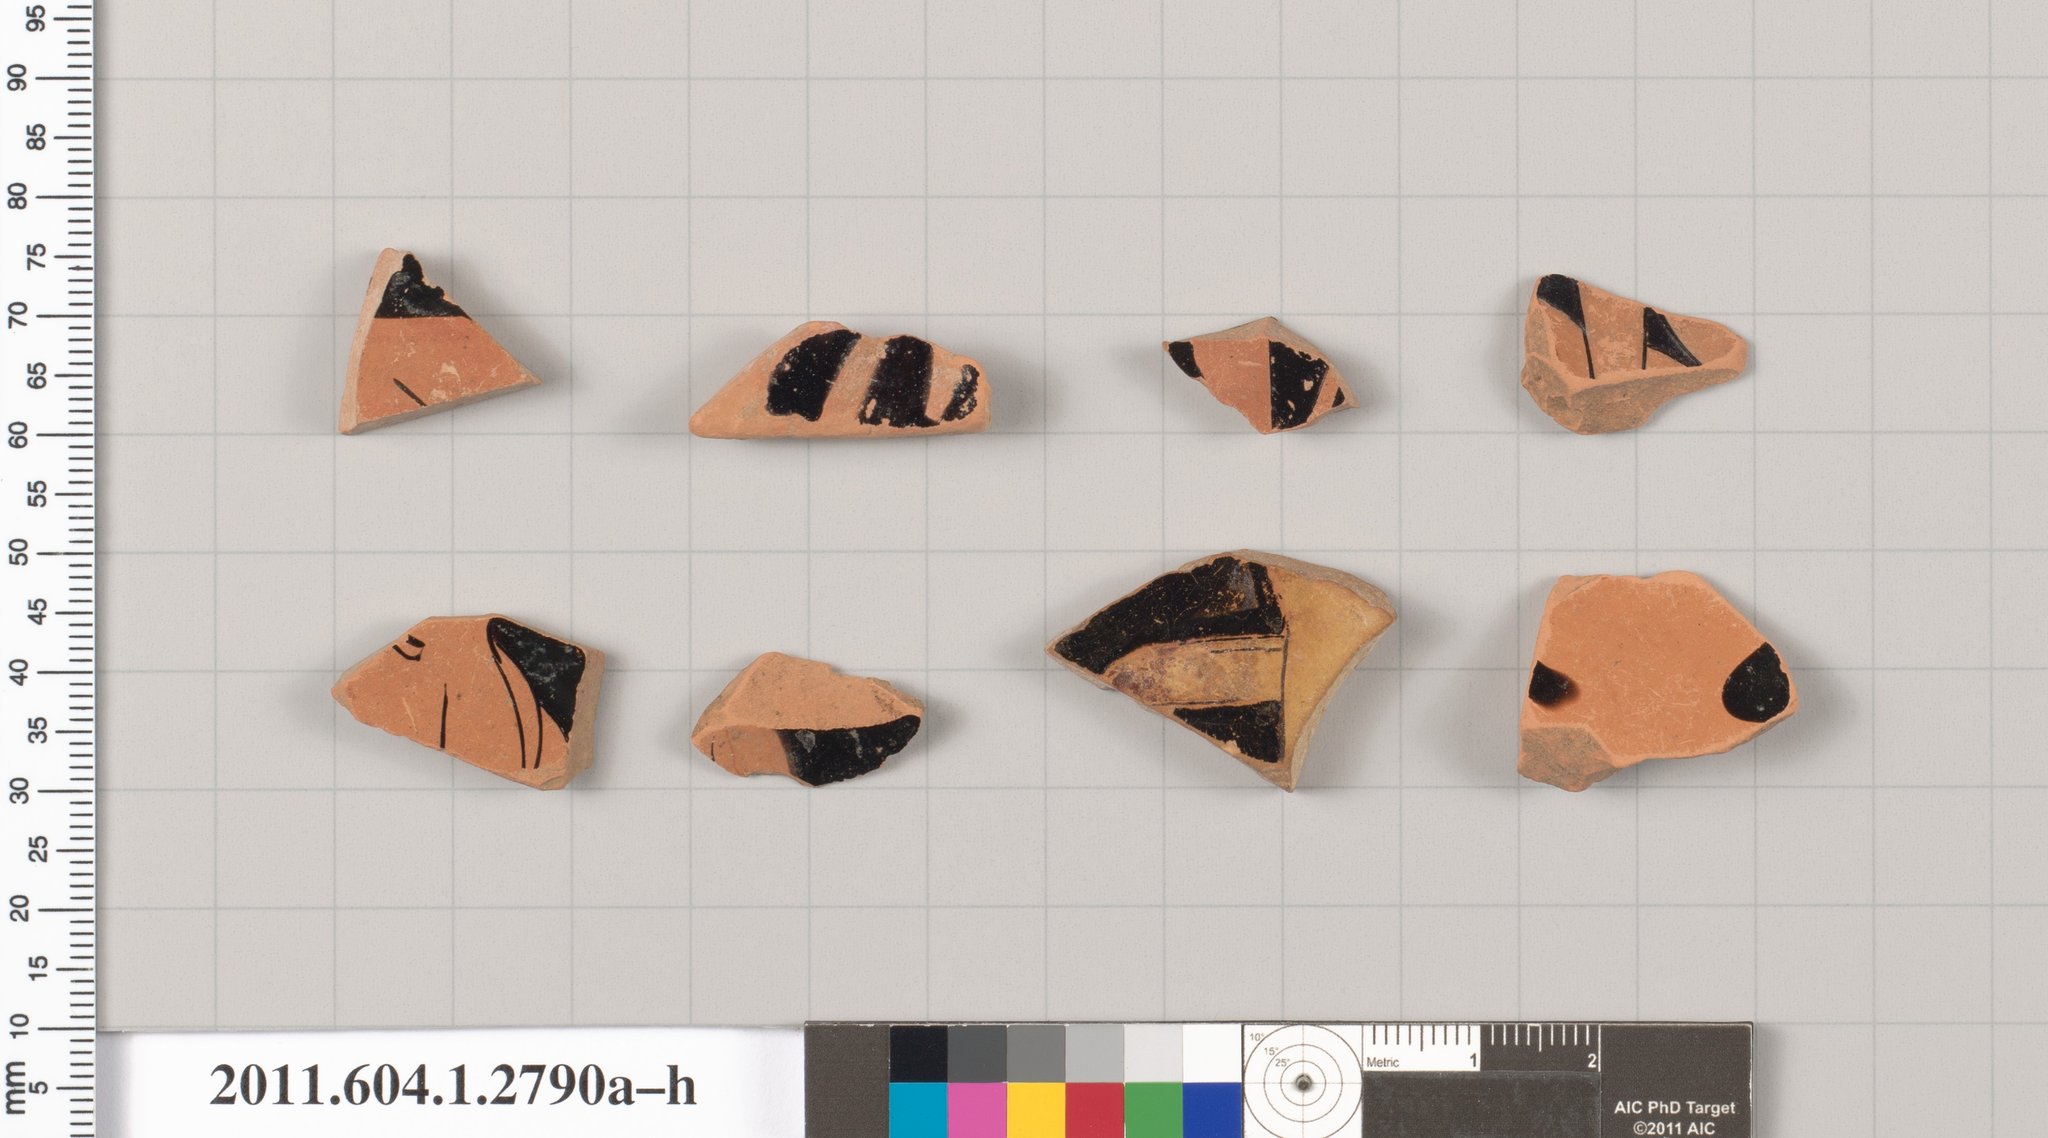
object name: kylix fragment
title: Terracotta fragments of kylikes (drinking cups)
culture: greek, attic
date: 500-401 BCE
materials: terracotta